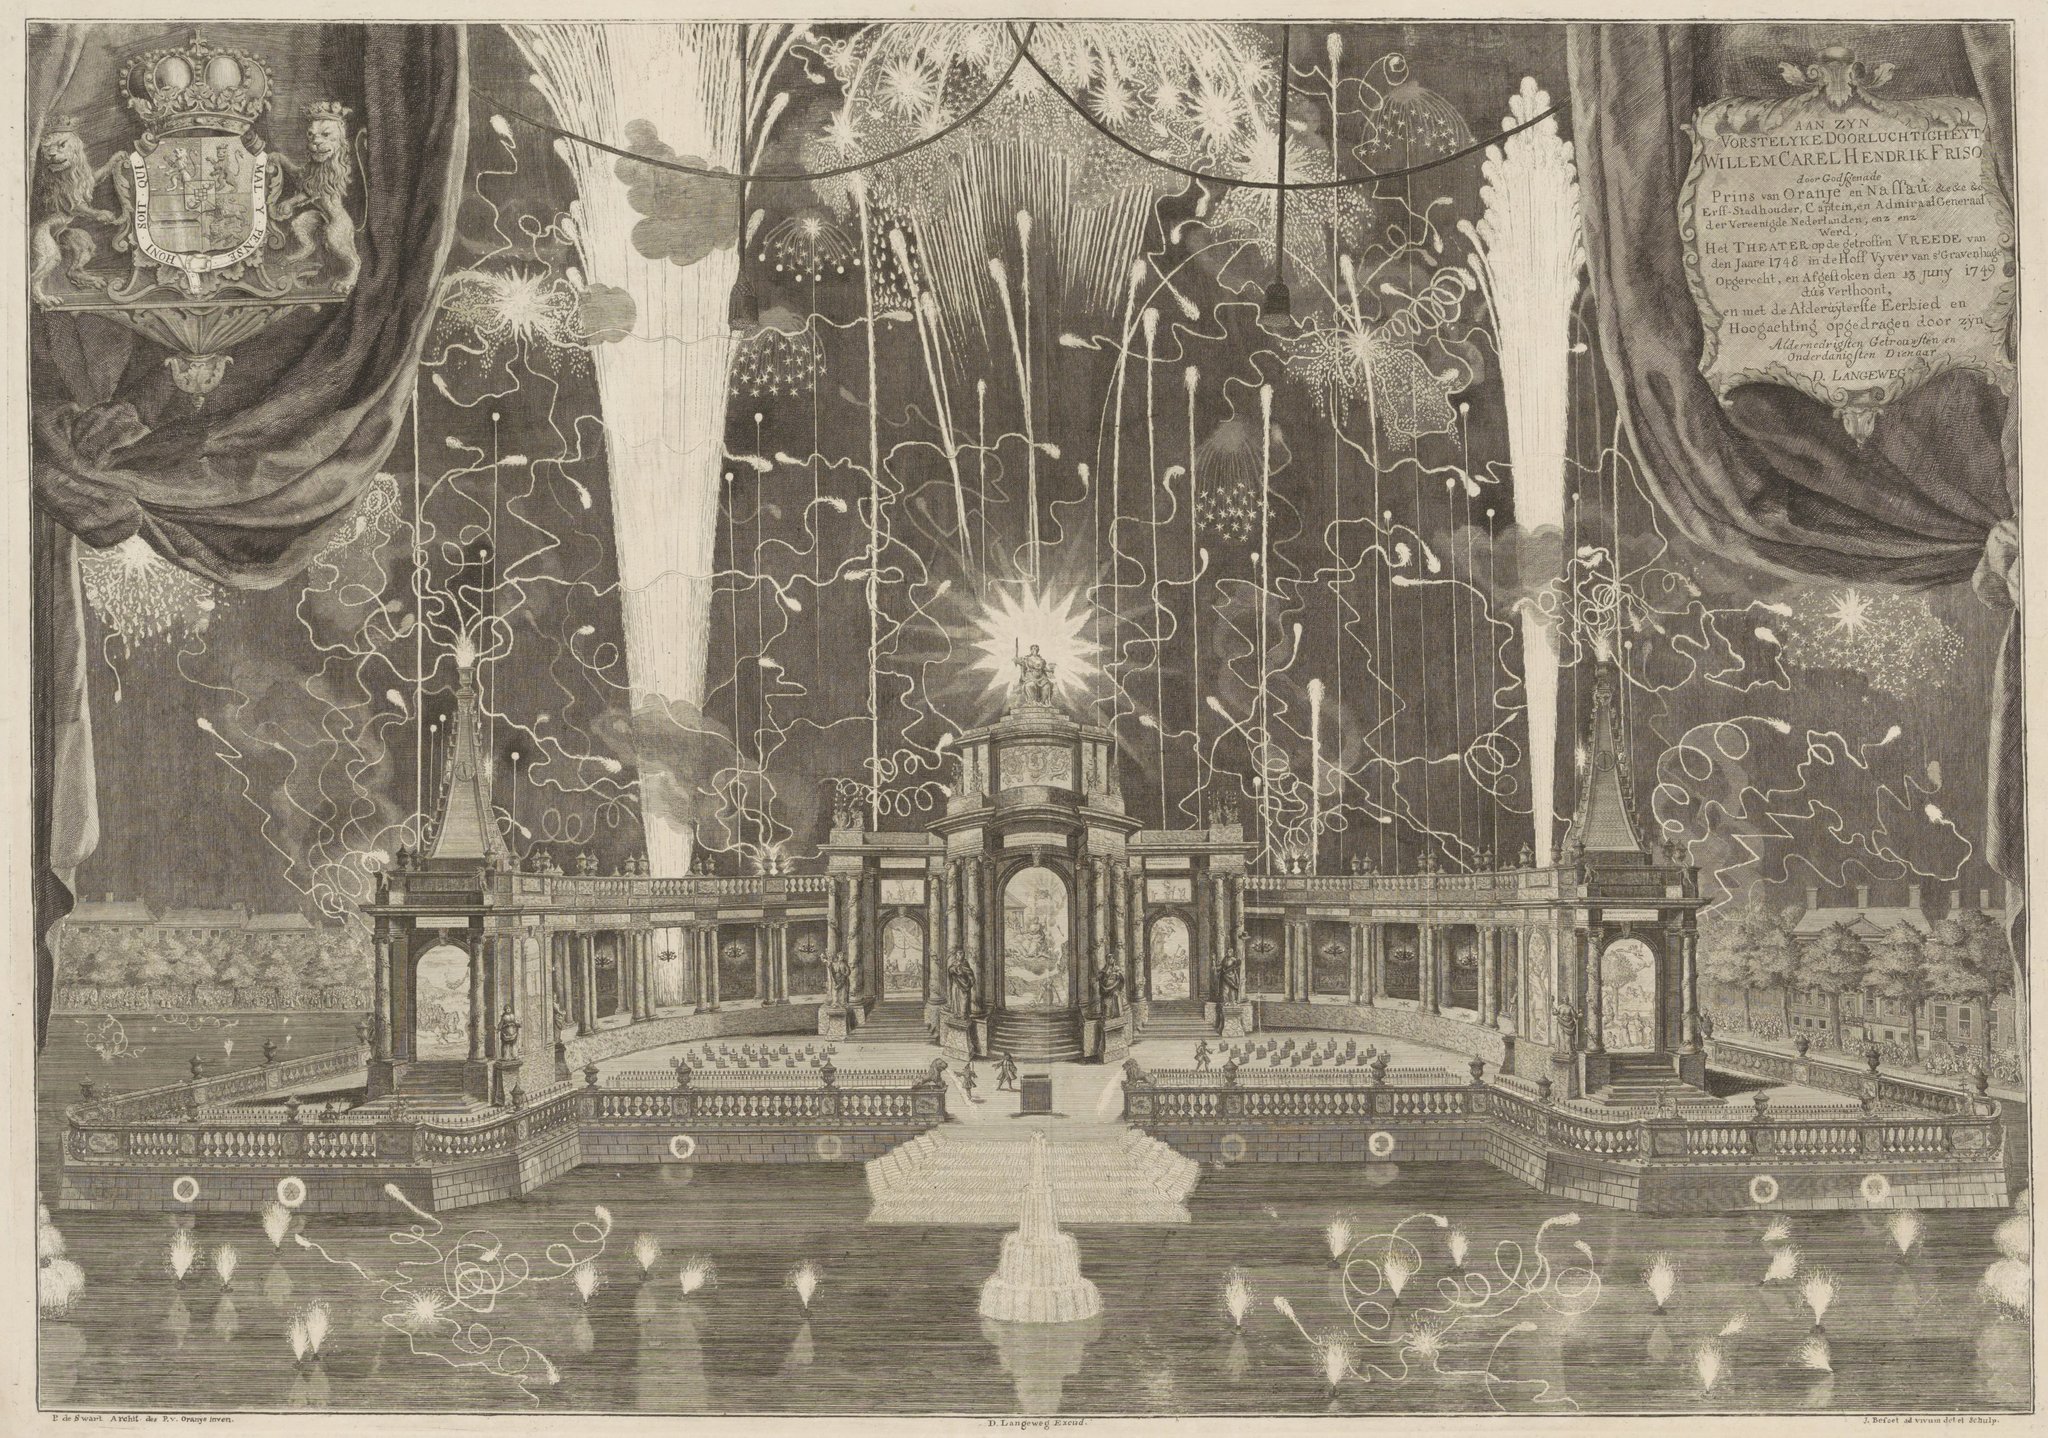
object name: print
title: Vuurwerk ter ere van de Vrede van Aken bij het paviljoen op de Hofvijver te Den Haag in 1749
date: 1749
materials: paper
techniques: engraving, etching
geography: the hague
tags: bonfire, fire-works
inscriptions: collector's mark: Lugt 2228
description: Vuurwerk op de Hofvijver in Den Haag bij het paviljoen gebouwd ter ere van de Vrede van Aken die werd gesloten op 18 oktober 1748. Het paviljoen werd ontworpen door hofarchitect Pieter de Swart en het feestelijk afsteken van het vuurwerk vond plaats op de avond van vrijdag 13 juni 1749 aldus het opschrift.